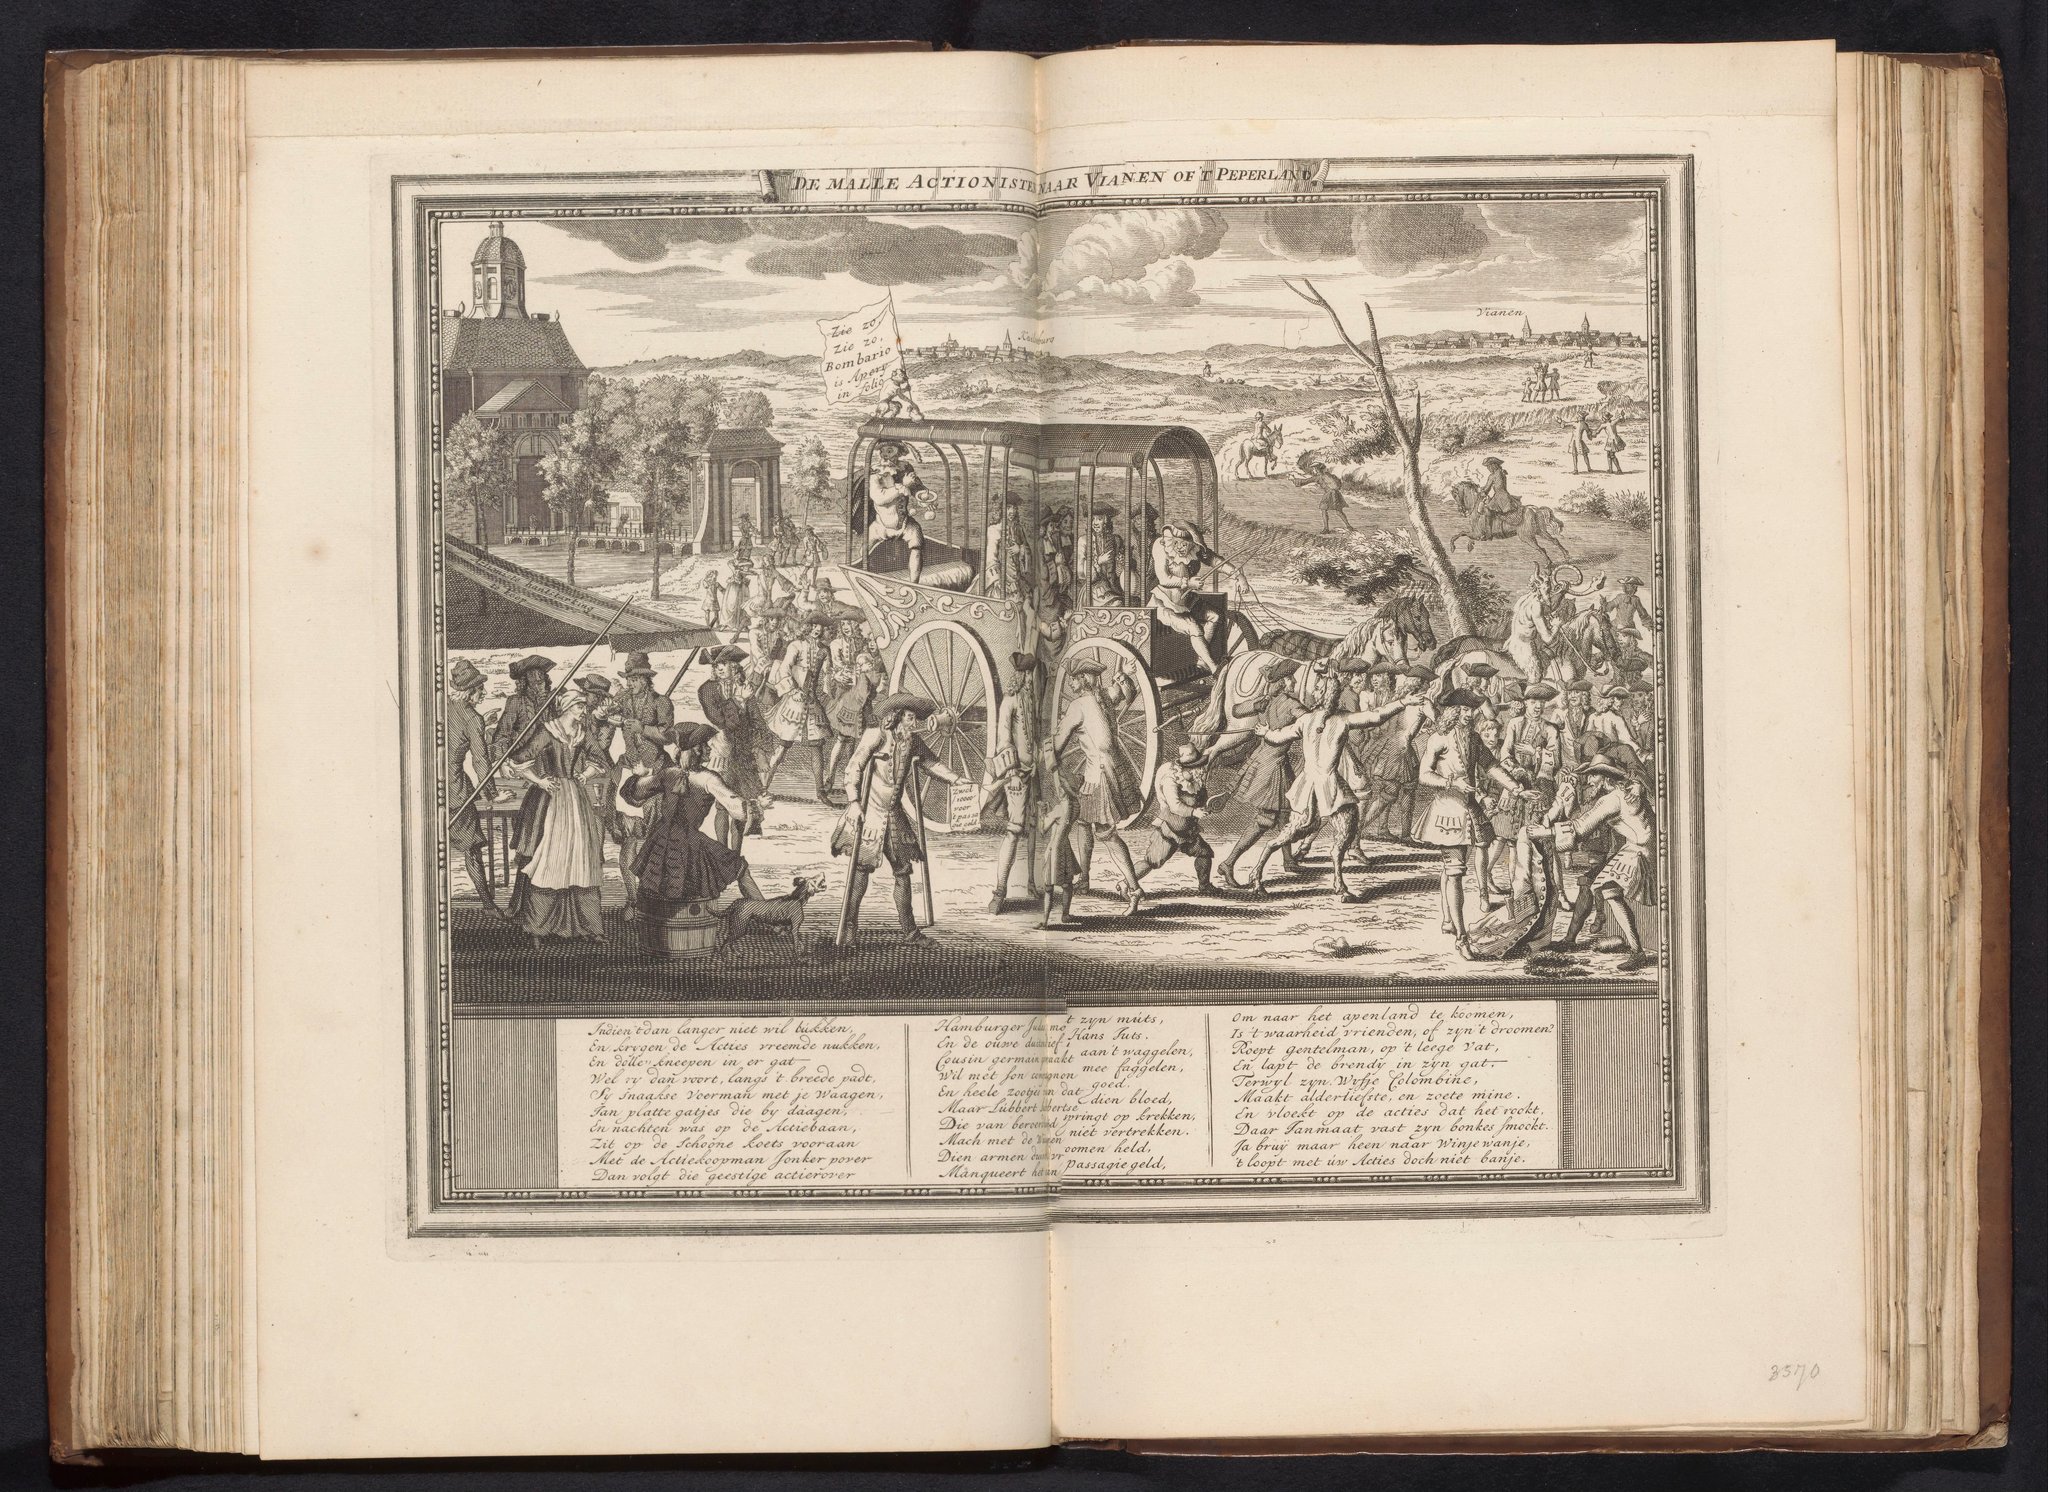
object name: cartoon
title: Actionisten onderweg naar Vianen, 1720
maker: Anonymous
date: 1720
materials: paper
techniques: etching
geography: northern netherlands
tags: four-wheeled vehicle drawn by three animals, financial panic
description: Een wagen met Actionisten verlaat Amsterdam bij de Muiderpoort en rijdt richting Vianen en Culemborg. De reiswagen wordt gemend door een nar, op het dak rijdt een aap met een vaandel met Bombario, de paarden worden geleid door een duivel. In en om de wagen actionisten of windhandelaren. In het onderschrift een tekst in drie verzen. Prent in de gebonden vierde uitgave (304 B 11) van Het Groote Tafereel der Dwaasheid met spotprenten op de Windhandel of Actiehandel van 1720.